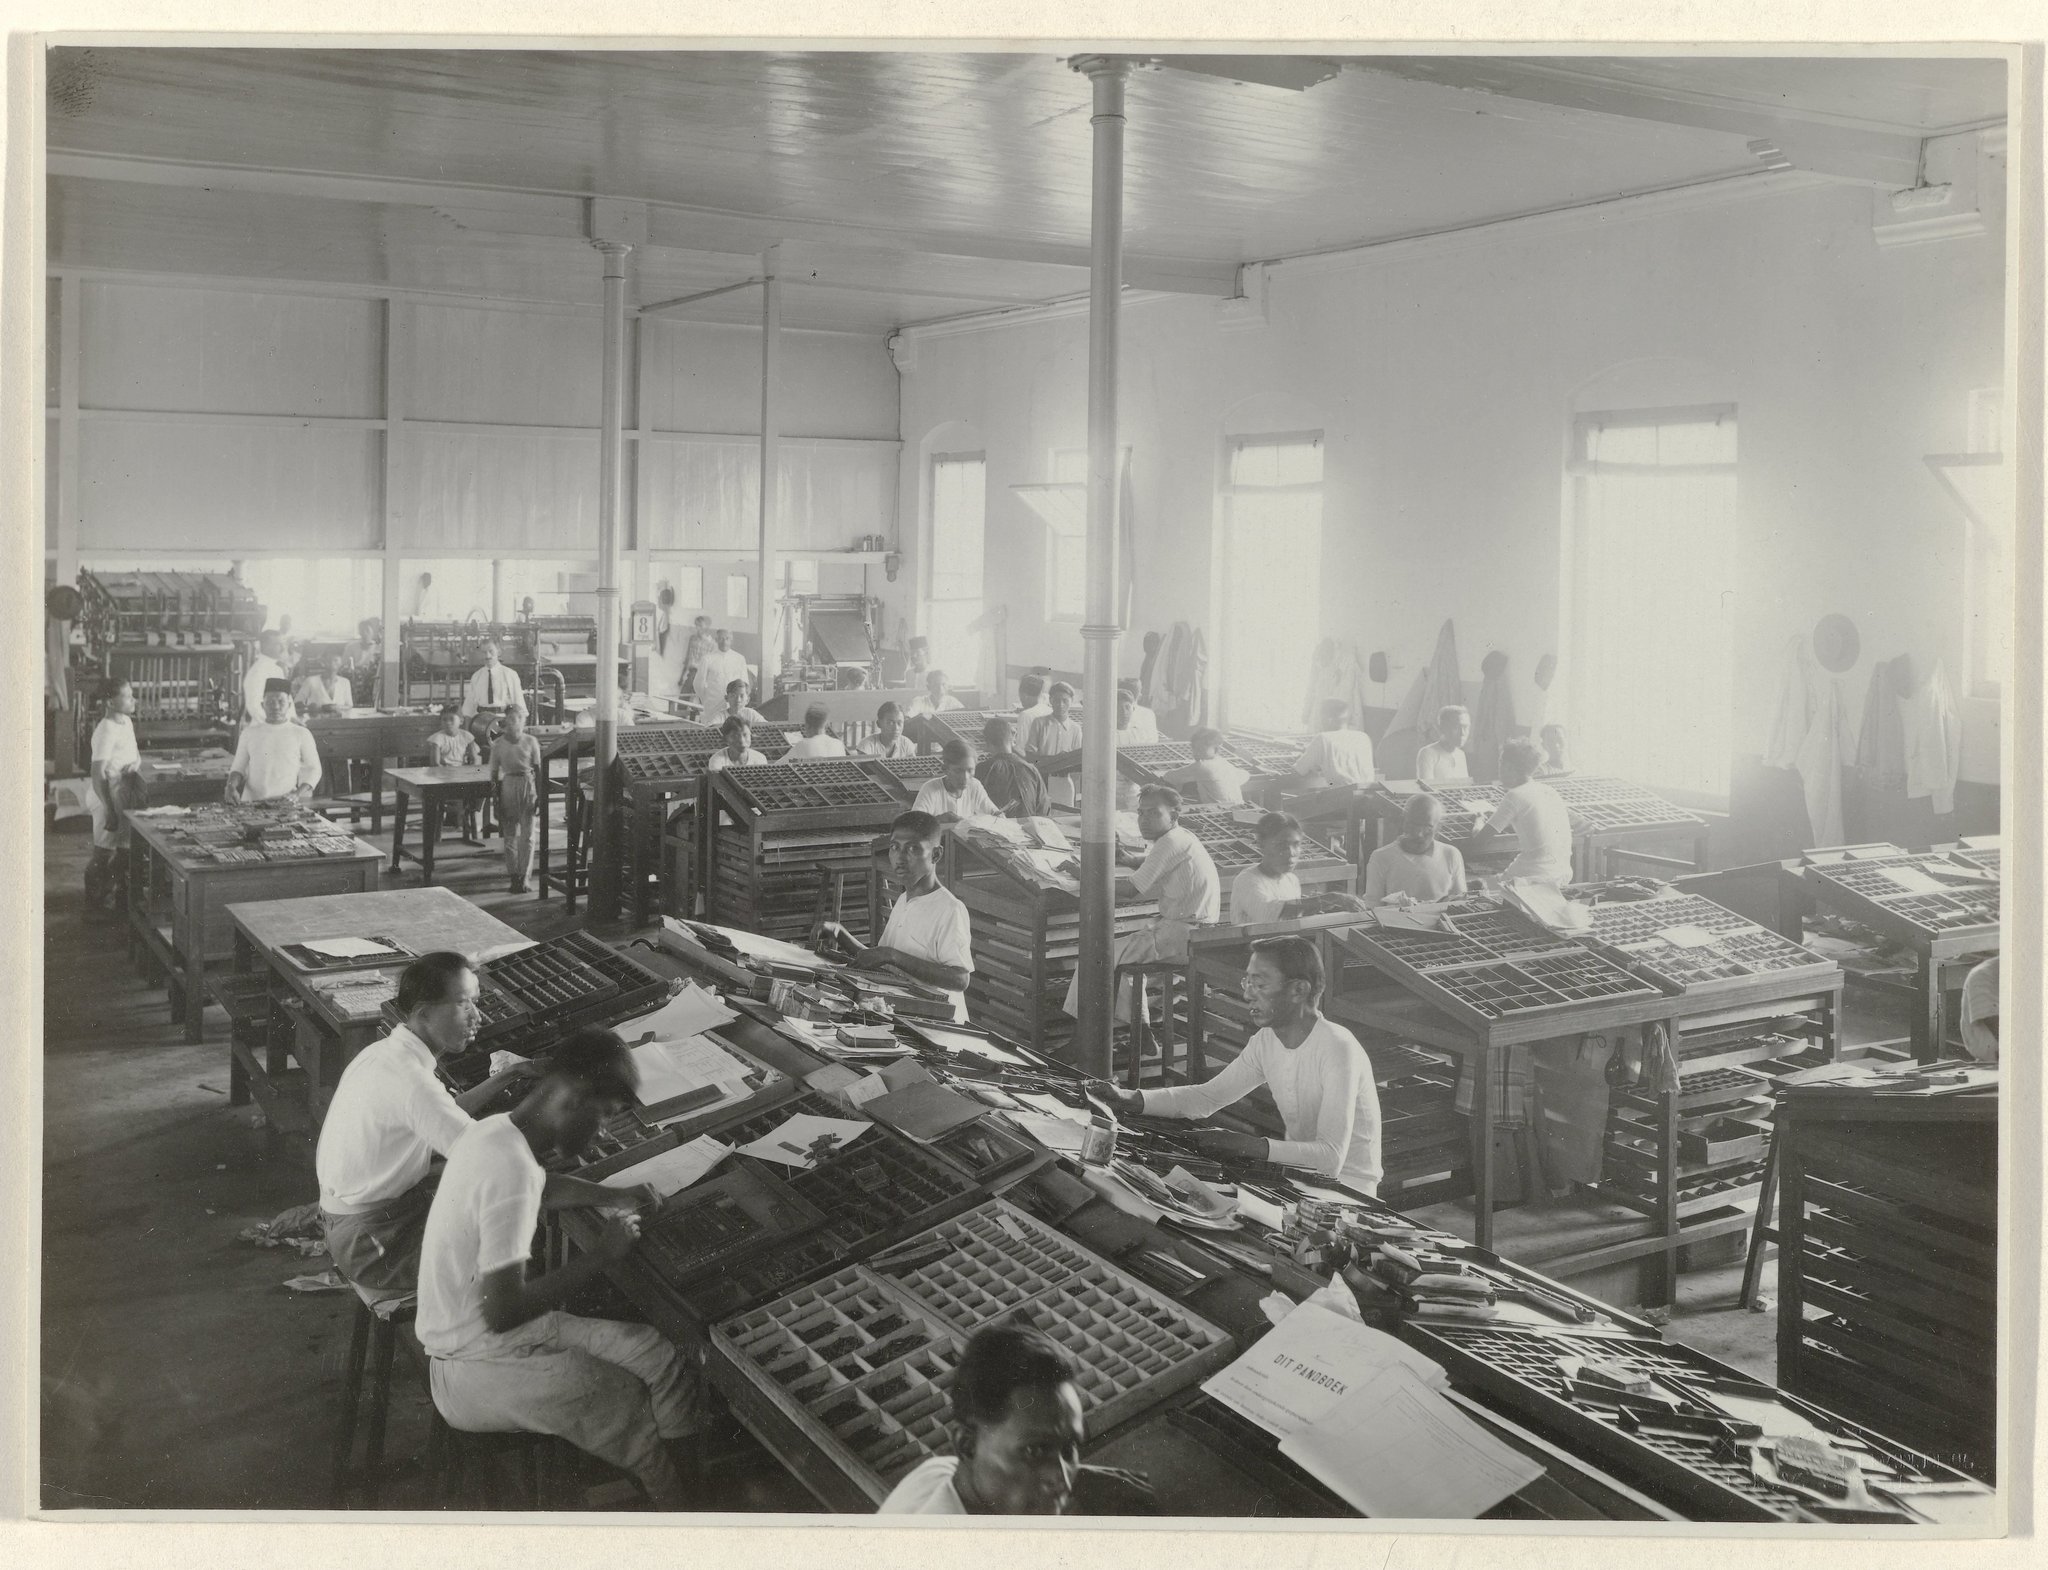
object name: photograph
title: Zetterij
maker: t. kaneo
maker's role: fotograaf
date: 1921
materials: photographic support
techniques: gelatin silver print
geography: medan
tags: dutch east indies, the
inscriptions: inscription: ‘Zetterij’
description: Gezicht in de zetterij met Javaanse werknemers op de drukkerij van de Deli Courant in Medan. Onderdeel van een groep van 18 foto's uit 1921 binnen de groep van 49 losse zwart-wit foto's van verschillend formaat over de uitgeverij en drukkerij van de krant Deli Courant in Medan in de periode 1885-1947.